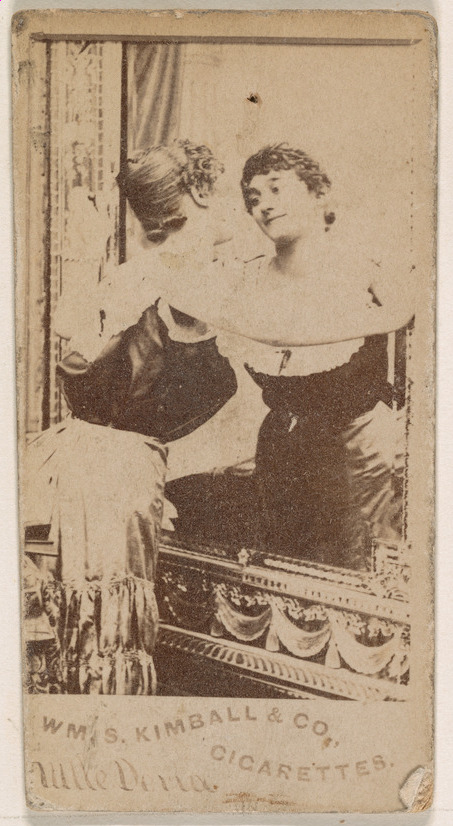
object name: photograph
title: Mlle Dana, from the Actresses series (N203) issued by Wm. S. Kimball & Co.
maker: william s. kimball & company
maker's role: publisher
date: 1889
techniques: color lithograph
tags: portraits,women,actresses,mirrors